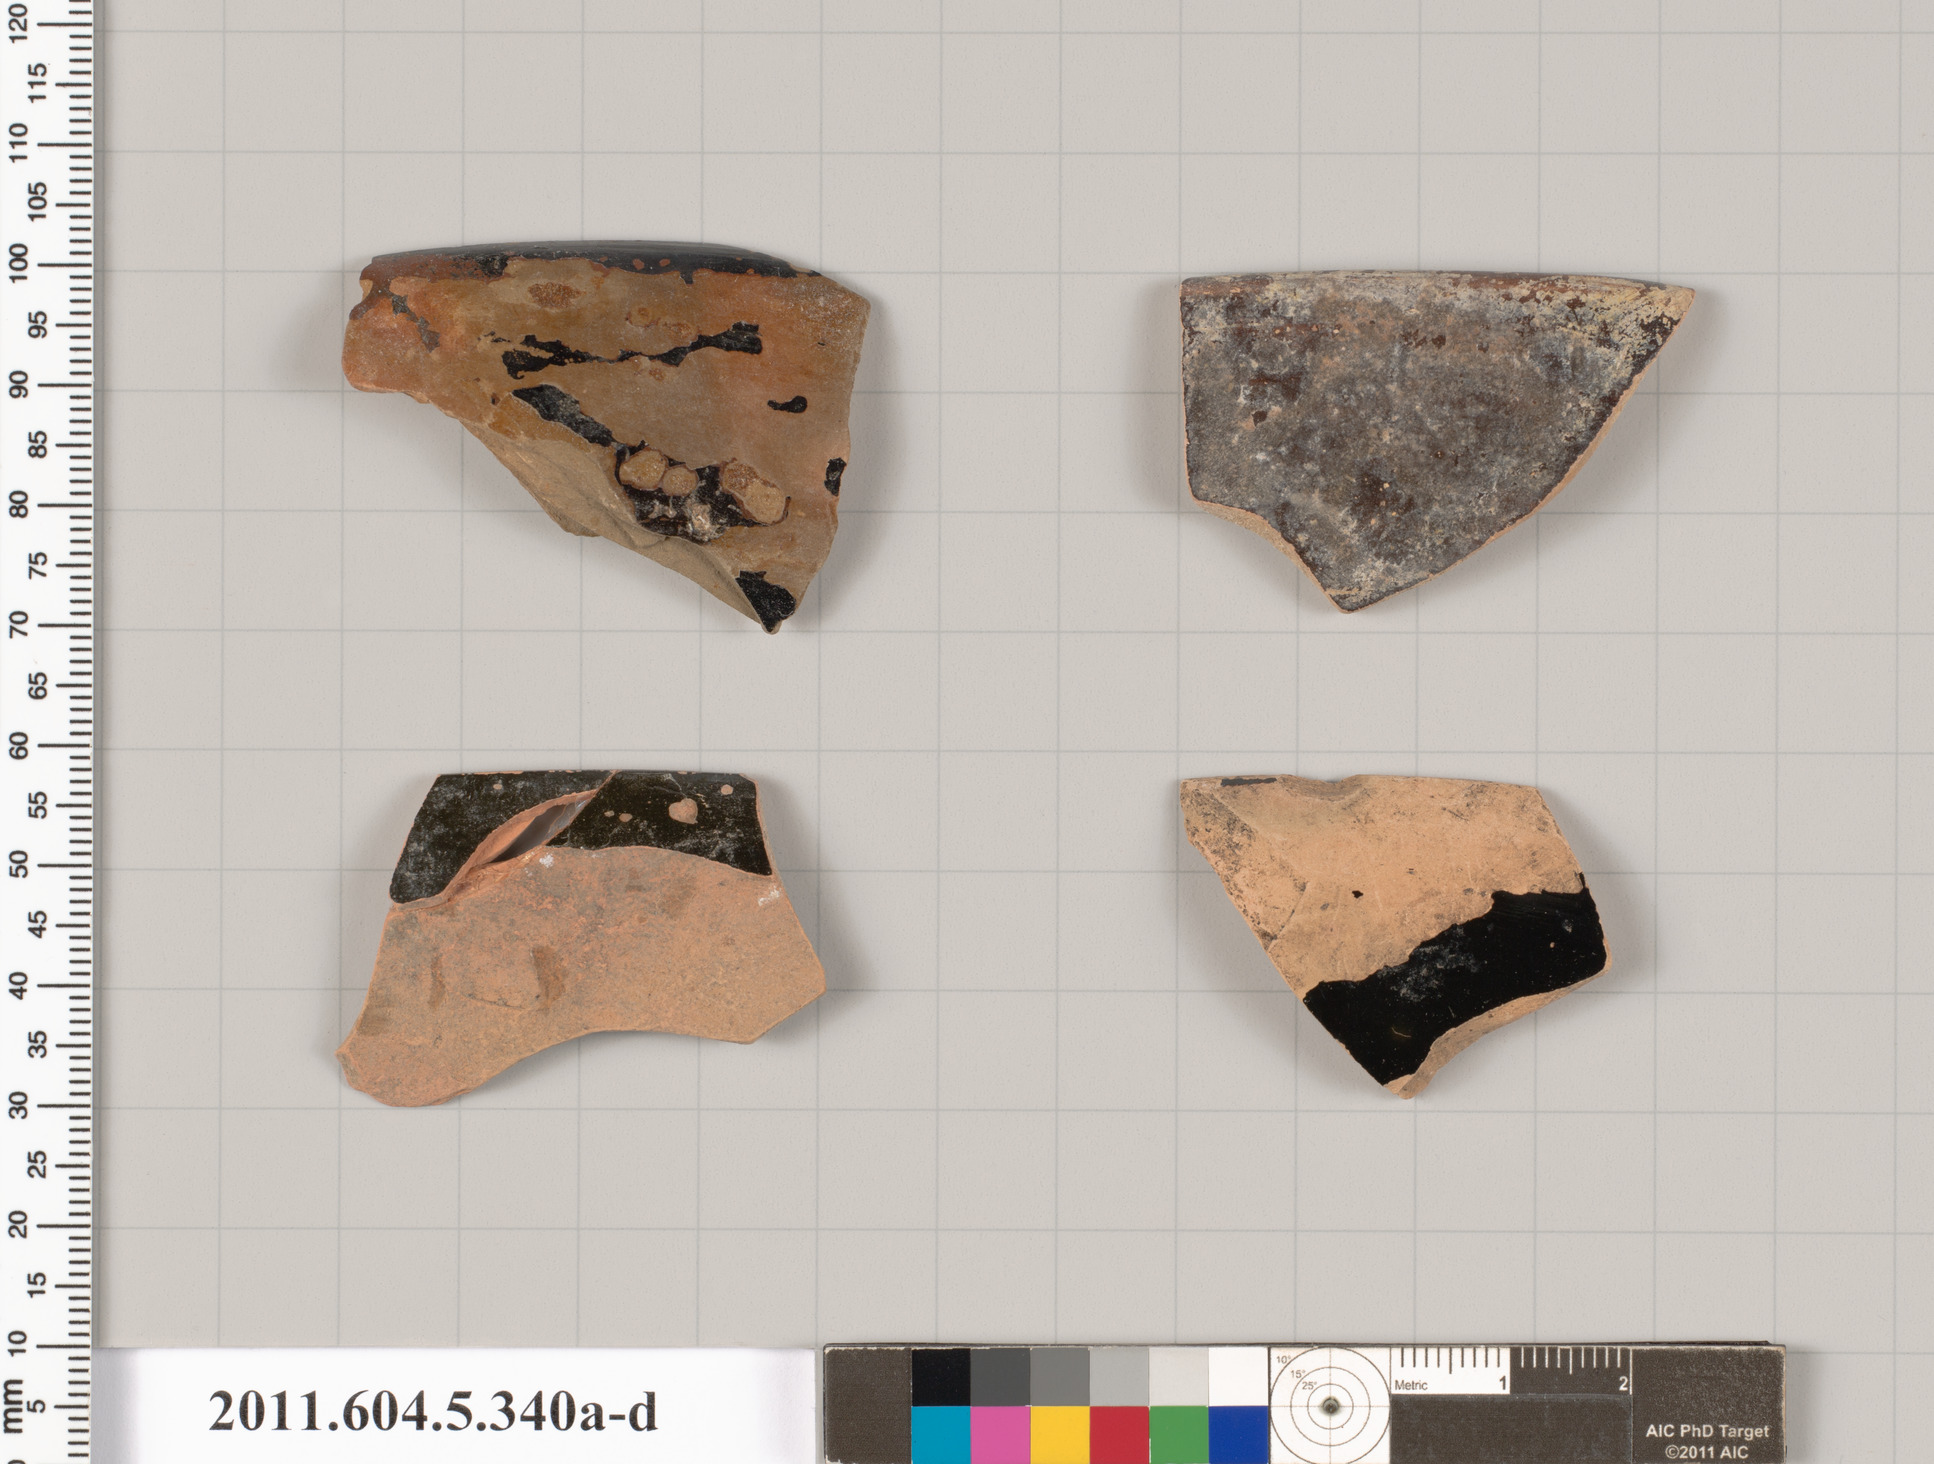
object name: kylix fragment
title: Terracotta rim fragments of kylikes (drinking cups)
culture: greek, attic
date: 600-401 BCE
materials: terracotta